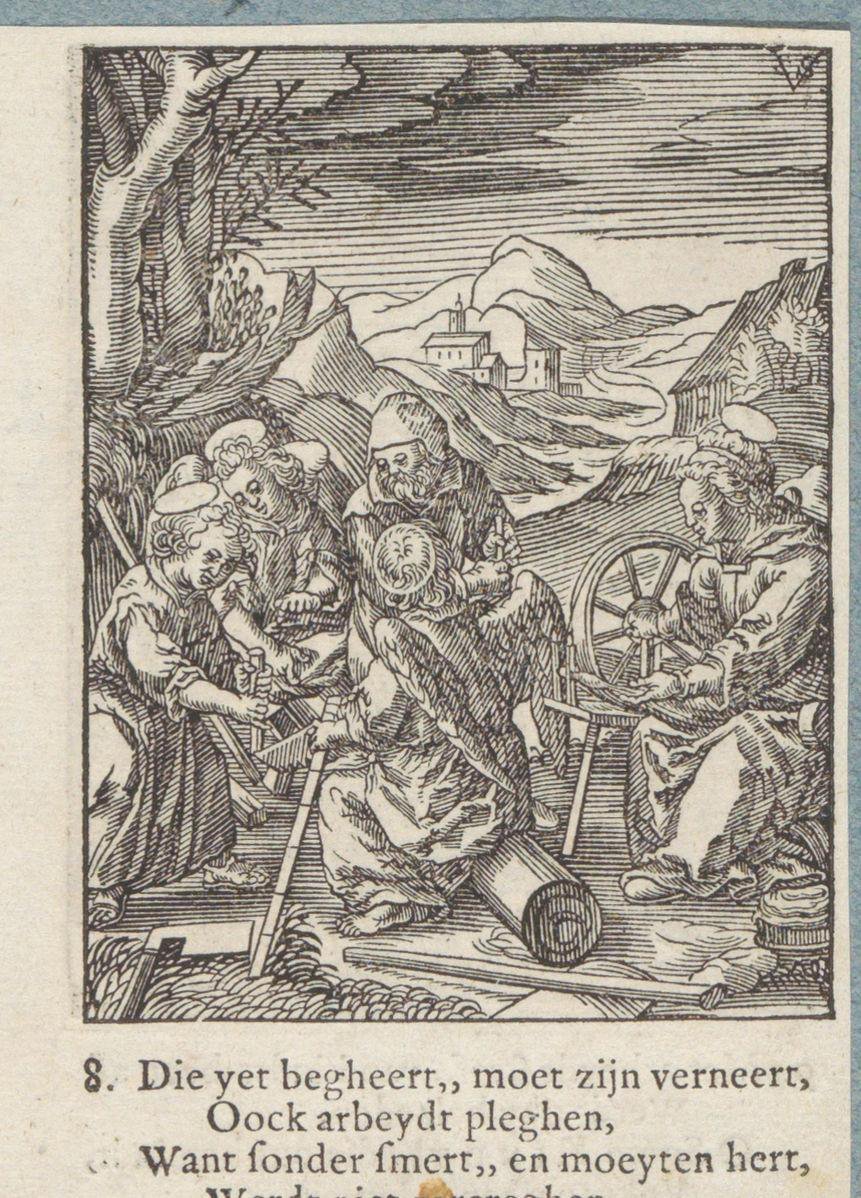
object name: book illustration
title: Christuskind zaagt een boomstam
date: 1617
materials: paper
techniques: letterpress printing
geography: amsterdam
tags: joseph and the christ-child ~ daily life in nazareth, angels, household occupations of mary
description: De prent verscheen in 1617 bij J.P. Paets als onderdeel van de serie over de jeugd van Christus. Daarnaast werd de houtsnede gebruikt in: Der Zielen Lust-hof. Leuven, I.Jacbosz voor P.J. Paets [= Amsterdam, P.J. Paets], 1629; Bibels Tresoor ofte der zielen lusthof. Amsterdam, P.J. Paets, 1646 en tSchat der Zielen. Amsterdam, P.J. Paets, 1648.